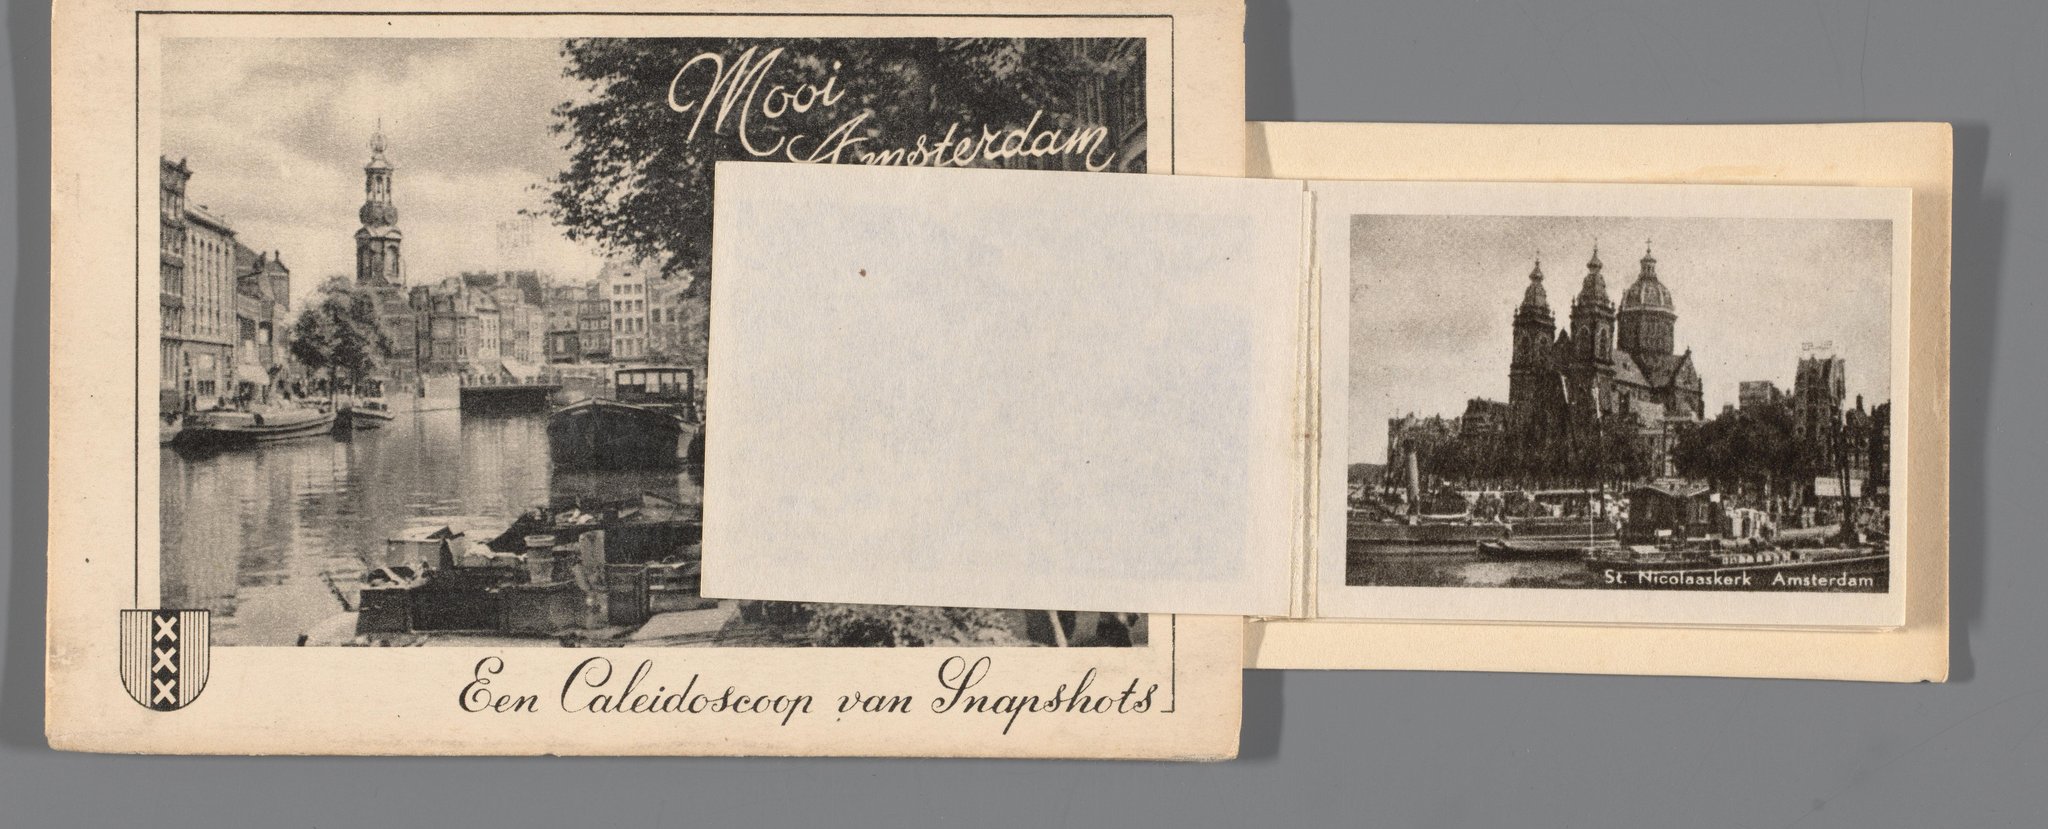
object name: photomechanical print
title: St. Nicolaaskerk Amsterdam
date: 1920-1950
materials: paper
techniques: rotogravure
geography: amsterdam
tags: church (exterior), canals, waters (in city)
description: Deze prent maakt deel uit van een omslag met tien prenten.